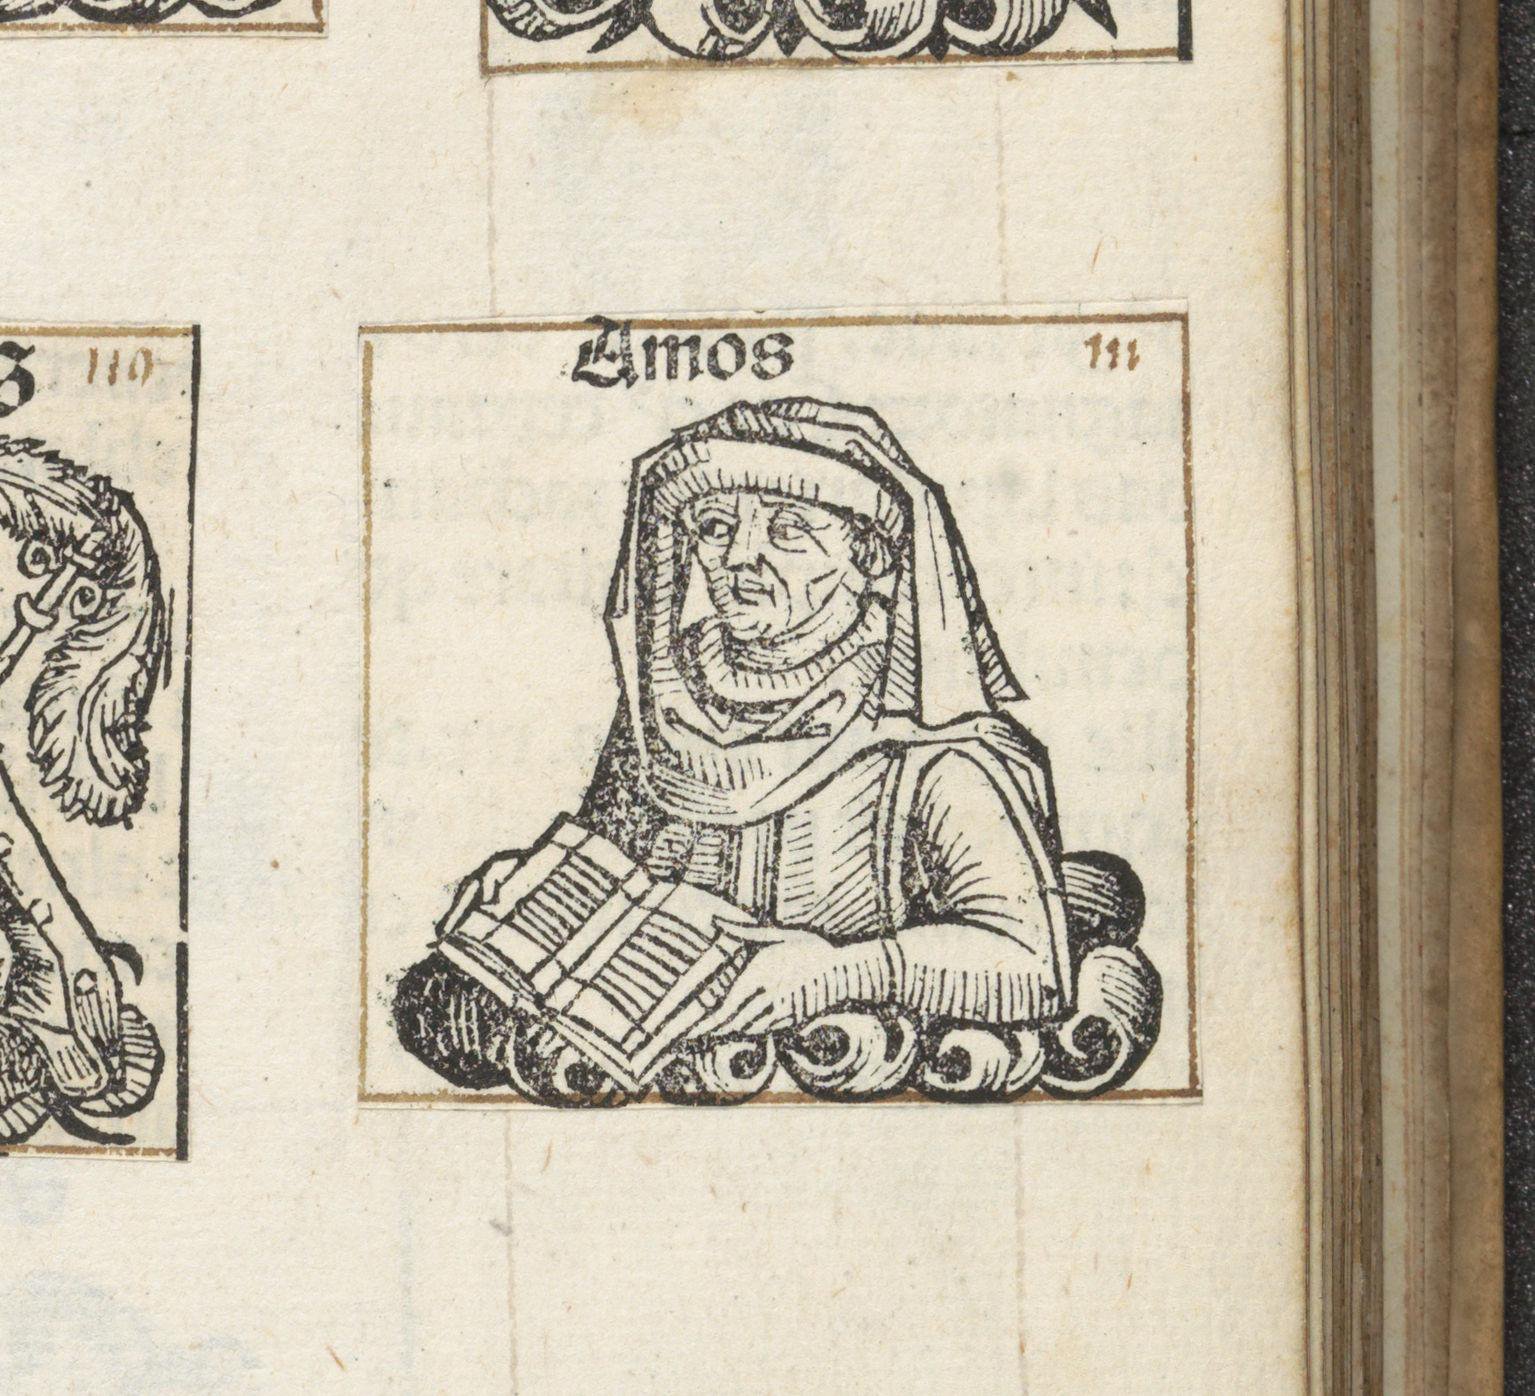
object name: album leaf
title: Amos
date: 1493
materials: paper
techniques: letterpress printing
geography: nuremberg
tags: reading, persons from the old testament (not in biblical context, nor occurring in legendary/historical extensions included in division 71)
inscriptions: inscription: ‘111’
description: Een bloemkelk met een man met kaproen en boek, naar links gericht. De voorstelling is een fragment van de lijn van de profeten van Israël in de Liber Chronicarum. De tekst identificeert hem de profeet Amos. De prent maakt deel uit van een album.